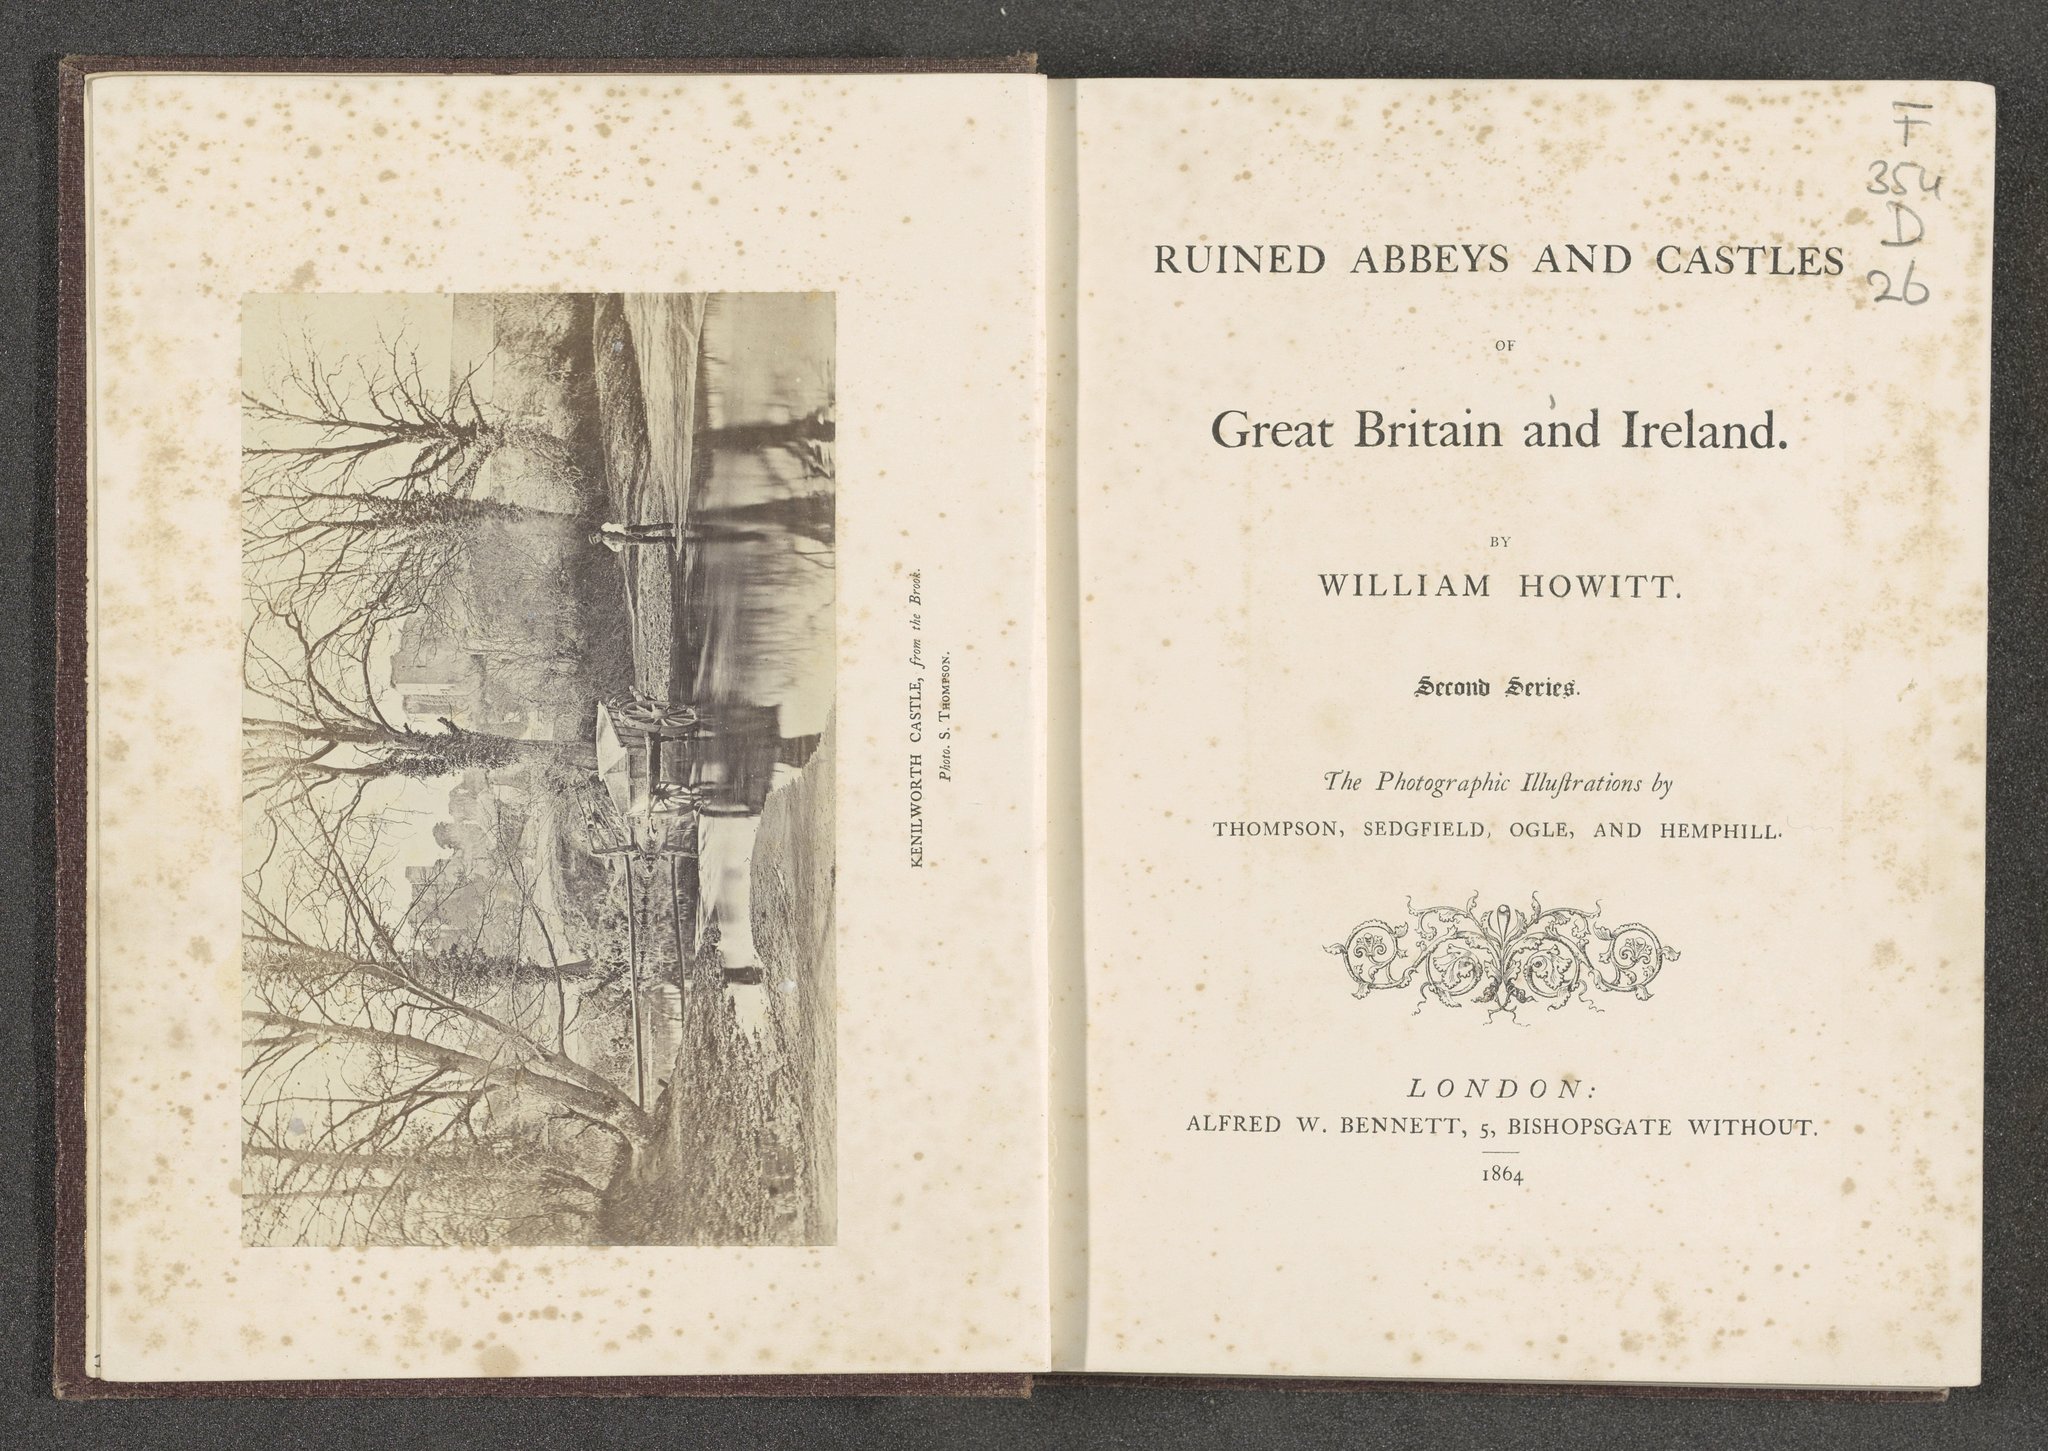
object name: book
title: Ruined abbeys and castles of Great Britain and Ireland second series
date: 1864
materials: linen, paper, photographic support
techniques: albumen print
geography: london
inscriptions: name: ‘Persevere Robert Thornton’